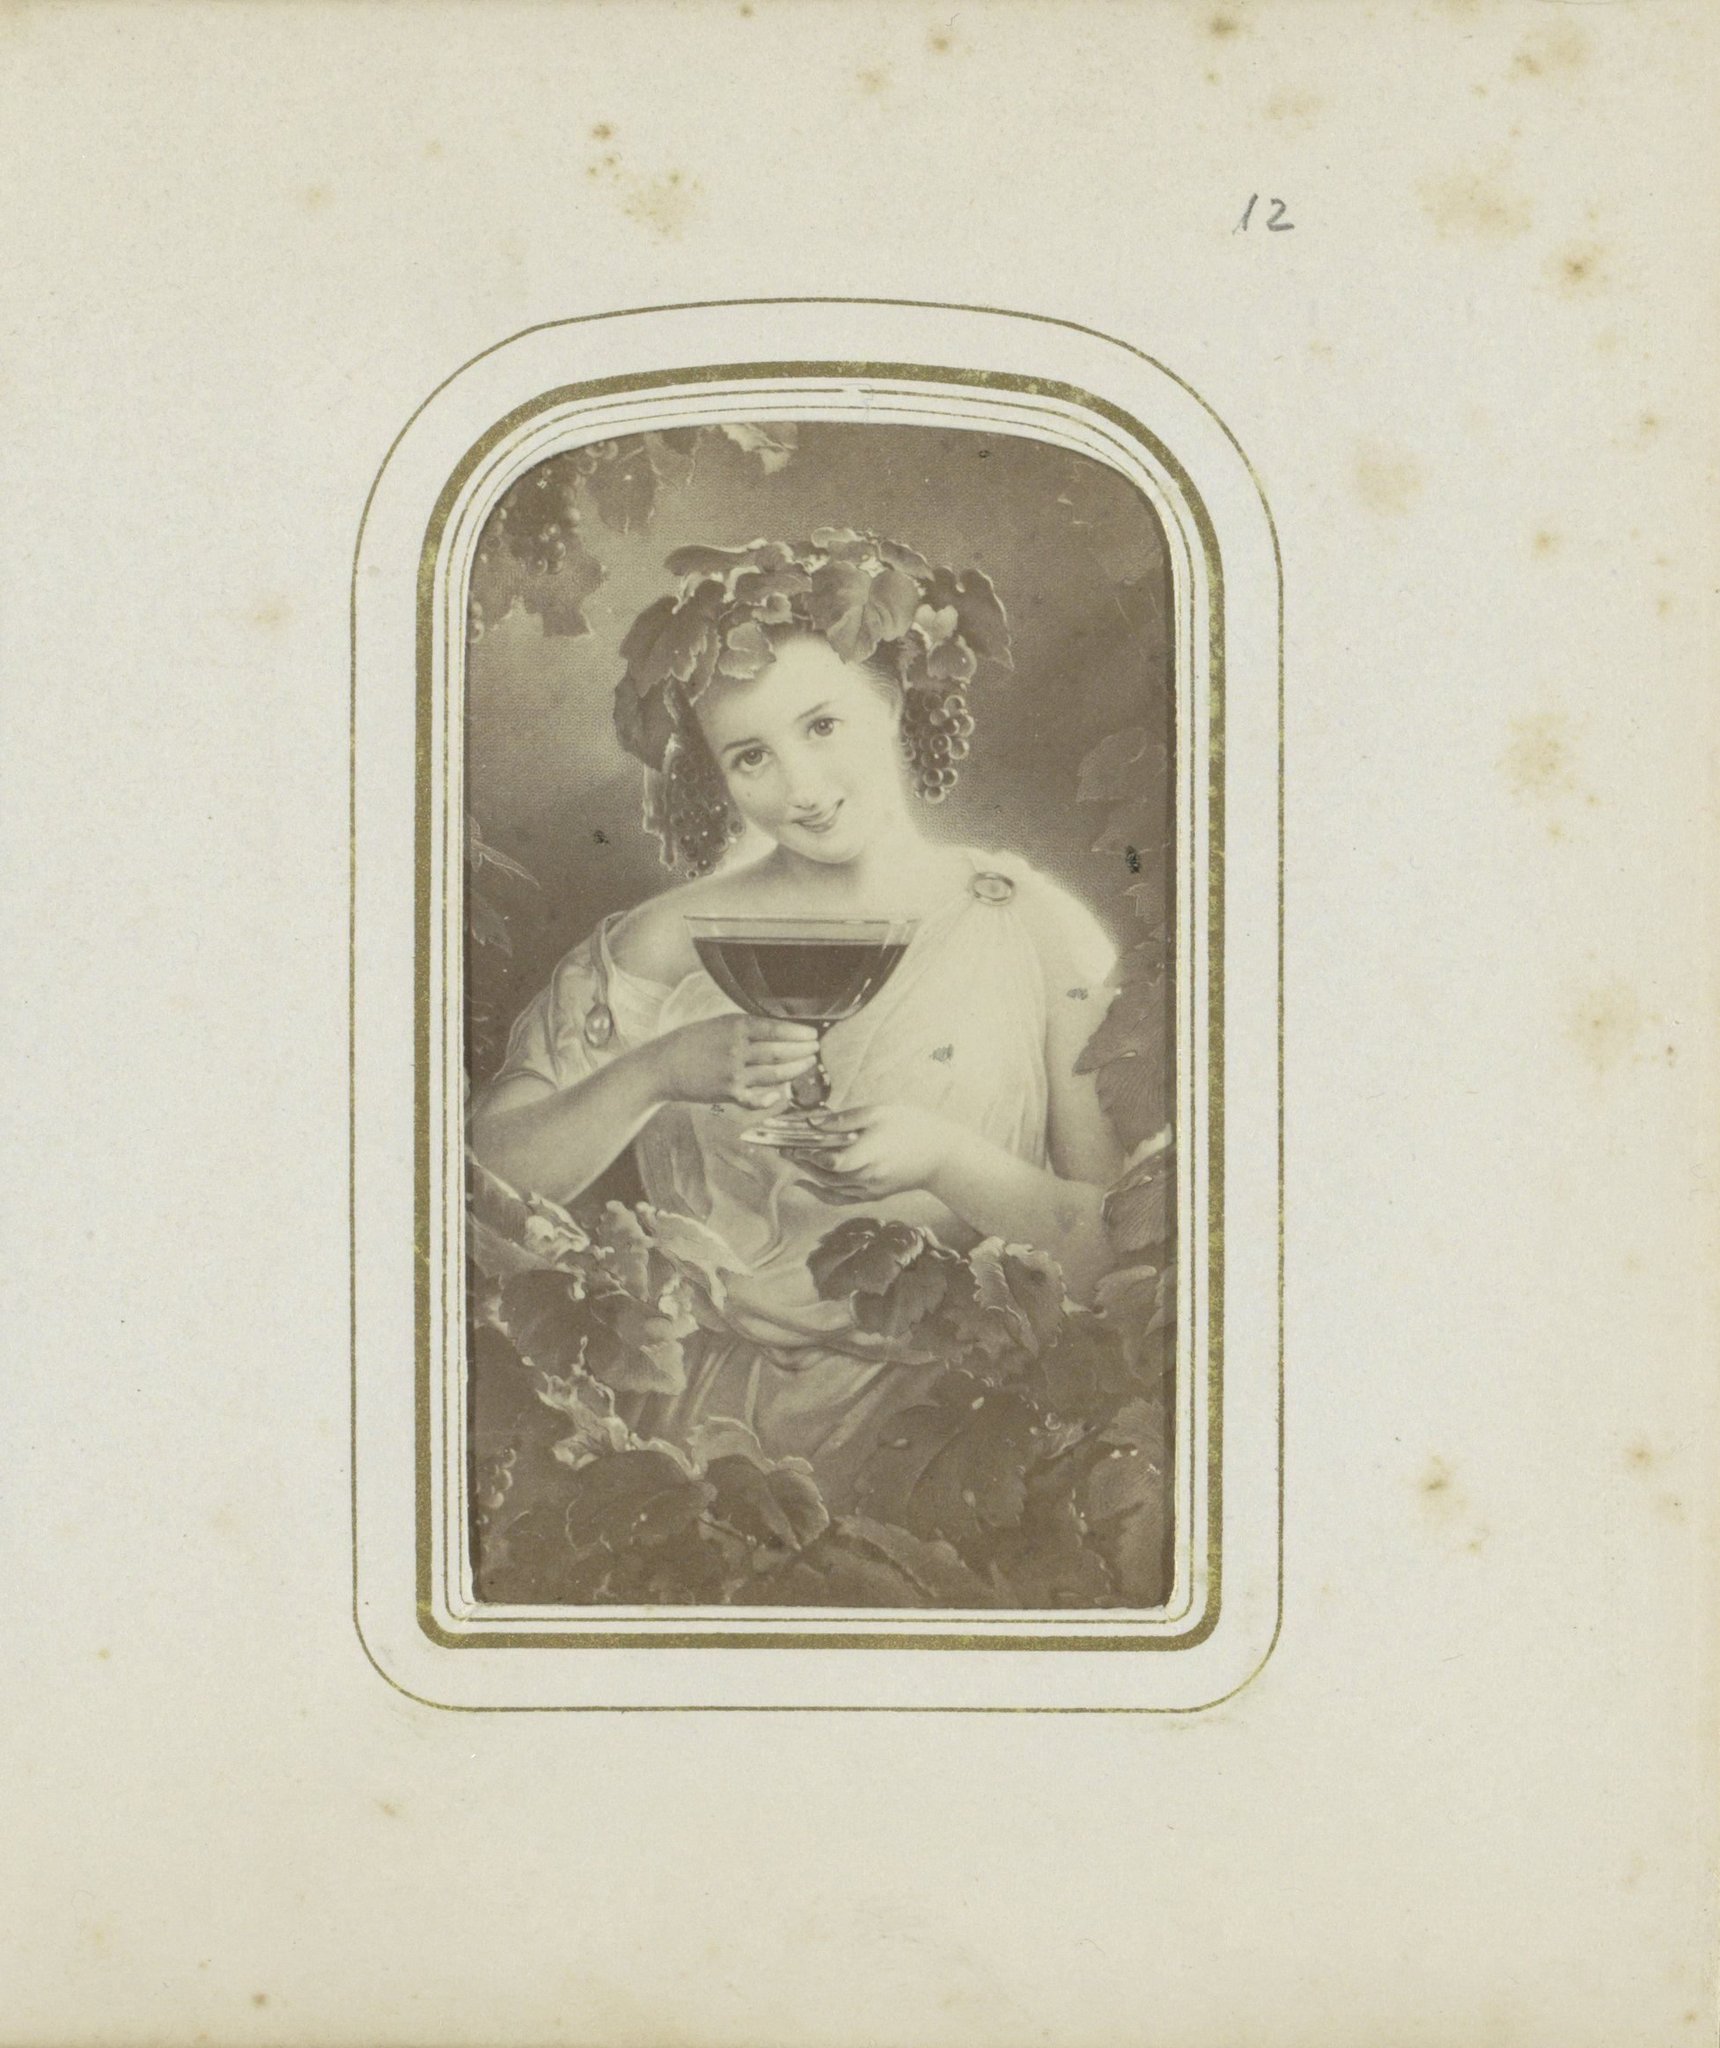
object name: photograph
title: Fotoreproductie van een schildering van een bacchante door August Riedel op Villa Rozenstein bij Stuttgart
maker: Anonymous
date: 1865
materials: paper, photographic support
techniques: albumen print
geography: germany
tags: maenad(s), female bacchant(es), travelling; tourism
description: Onderdeel van Fotoalbum van een reis door Zwitserland, Oostenrijk en Duitsland door de Nederlandse familie Derkinderen.